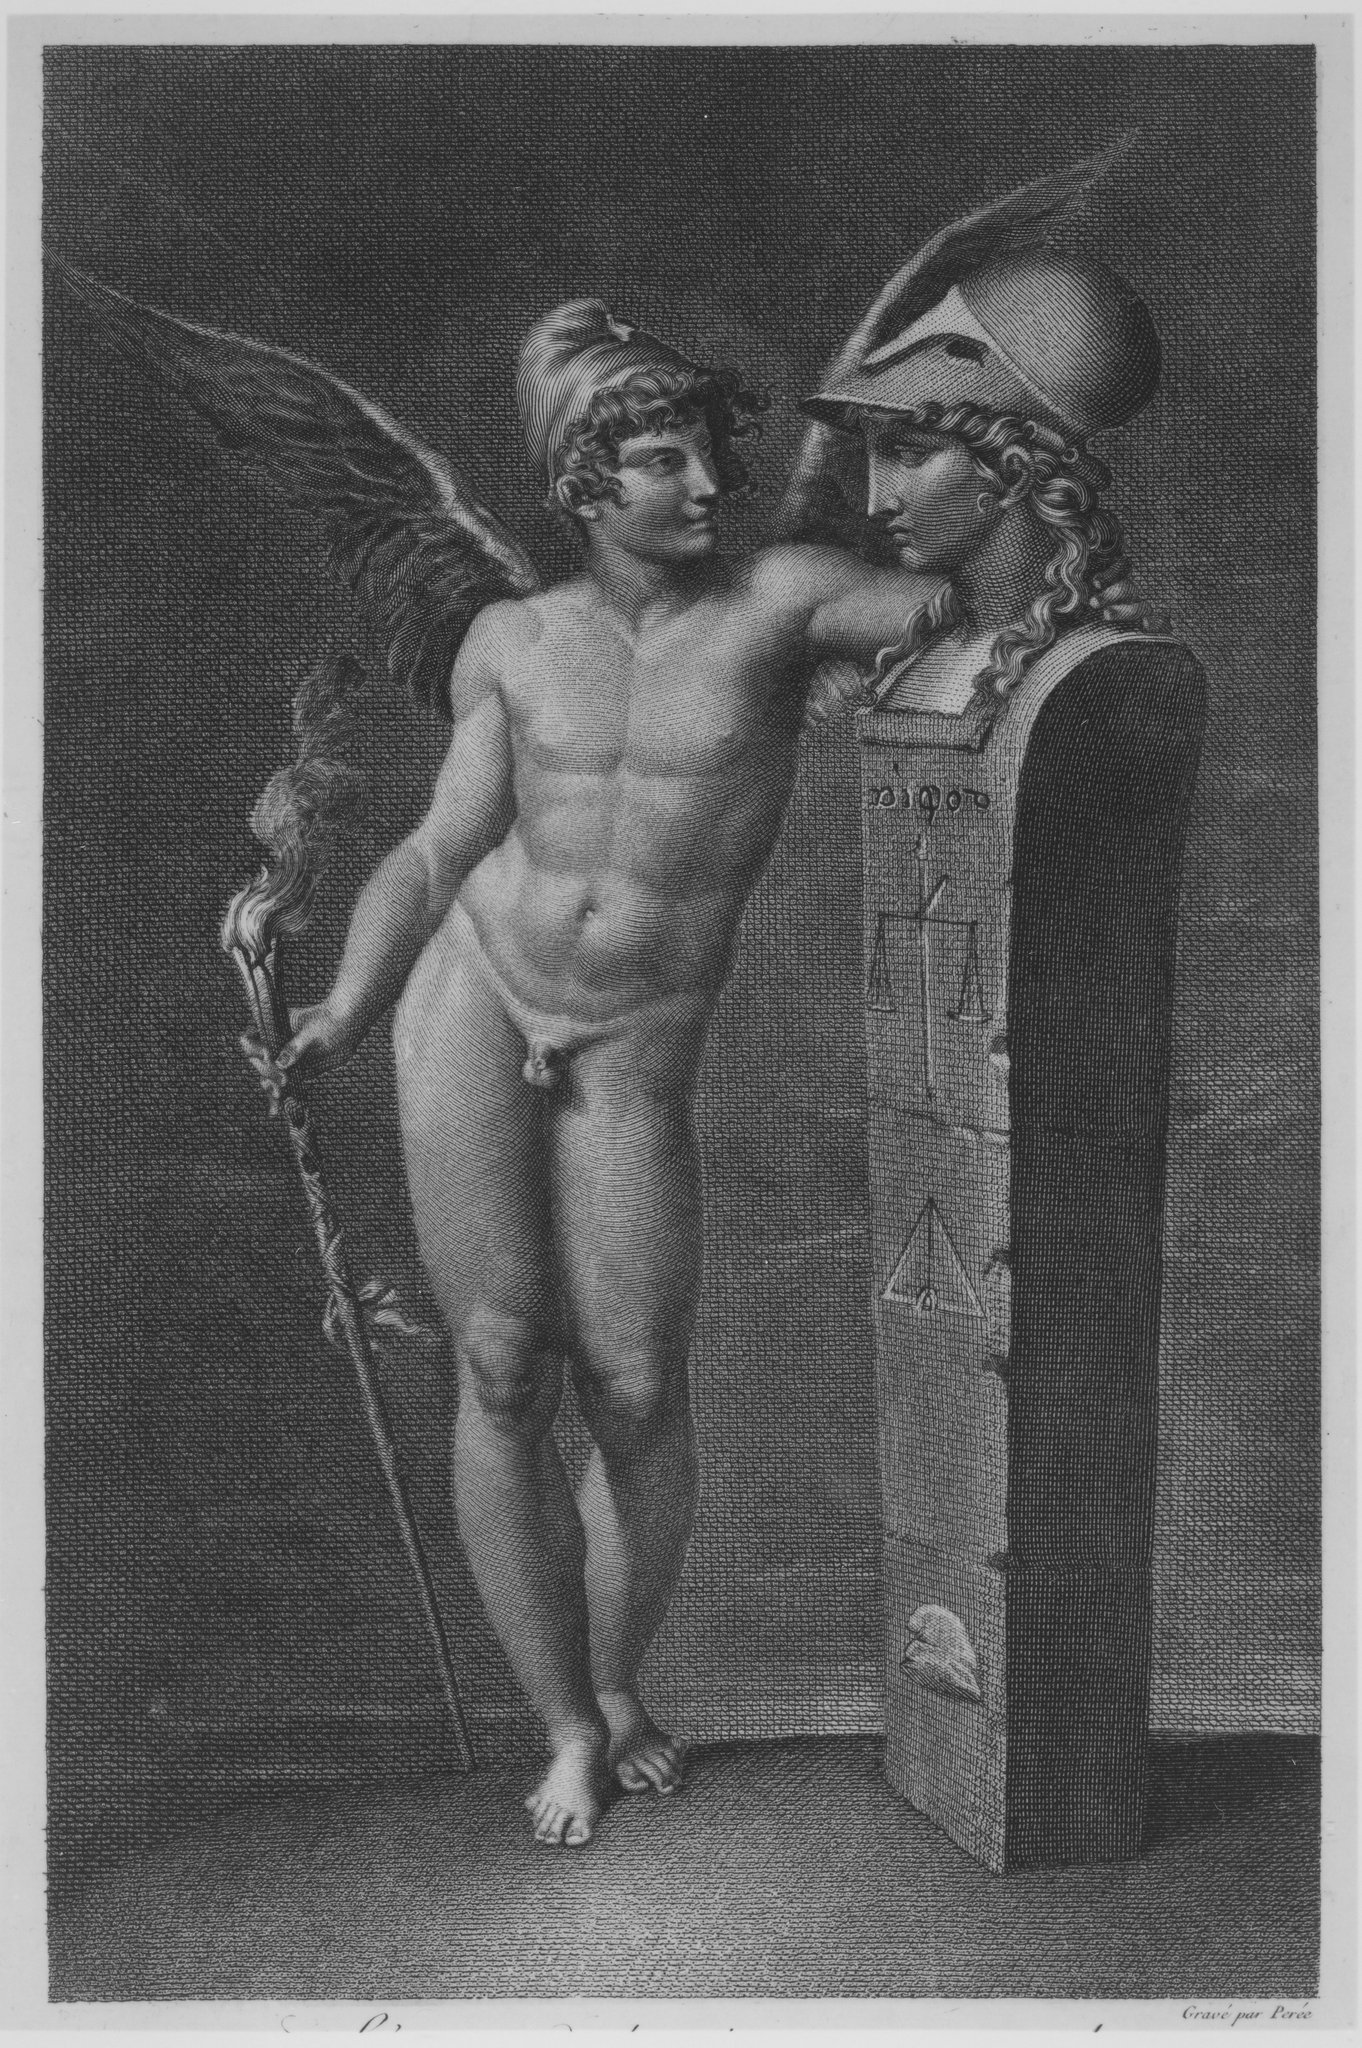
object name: print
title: The Spirit of Liberty Establishes the Empire of Wisdom on Earth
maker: pierre paul prud'hon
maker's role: artist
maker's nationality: french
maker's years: 1758-1823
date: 1791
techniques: engraving, etching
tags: heads